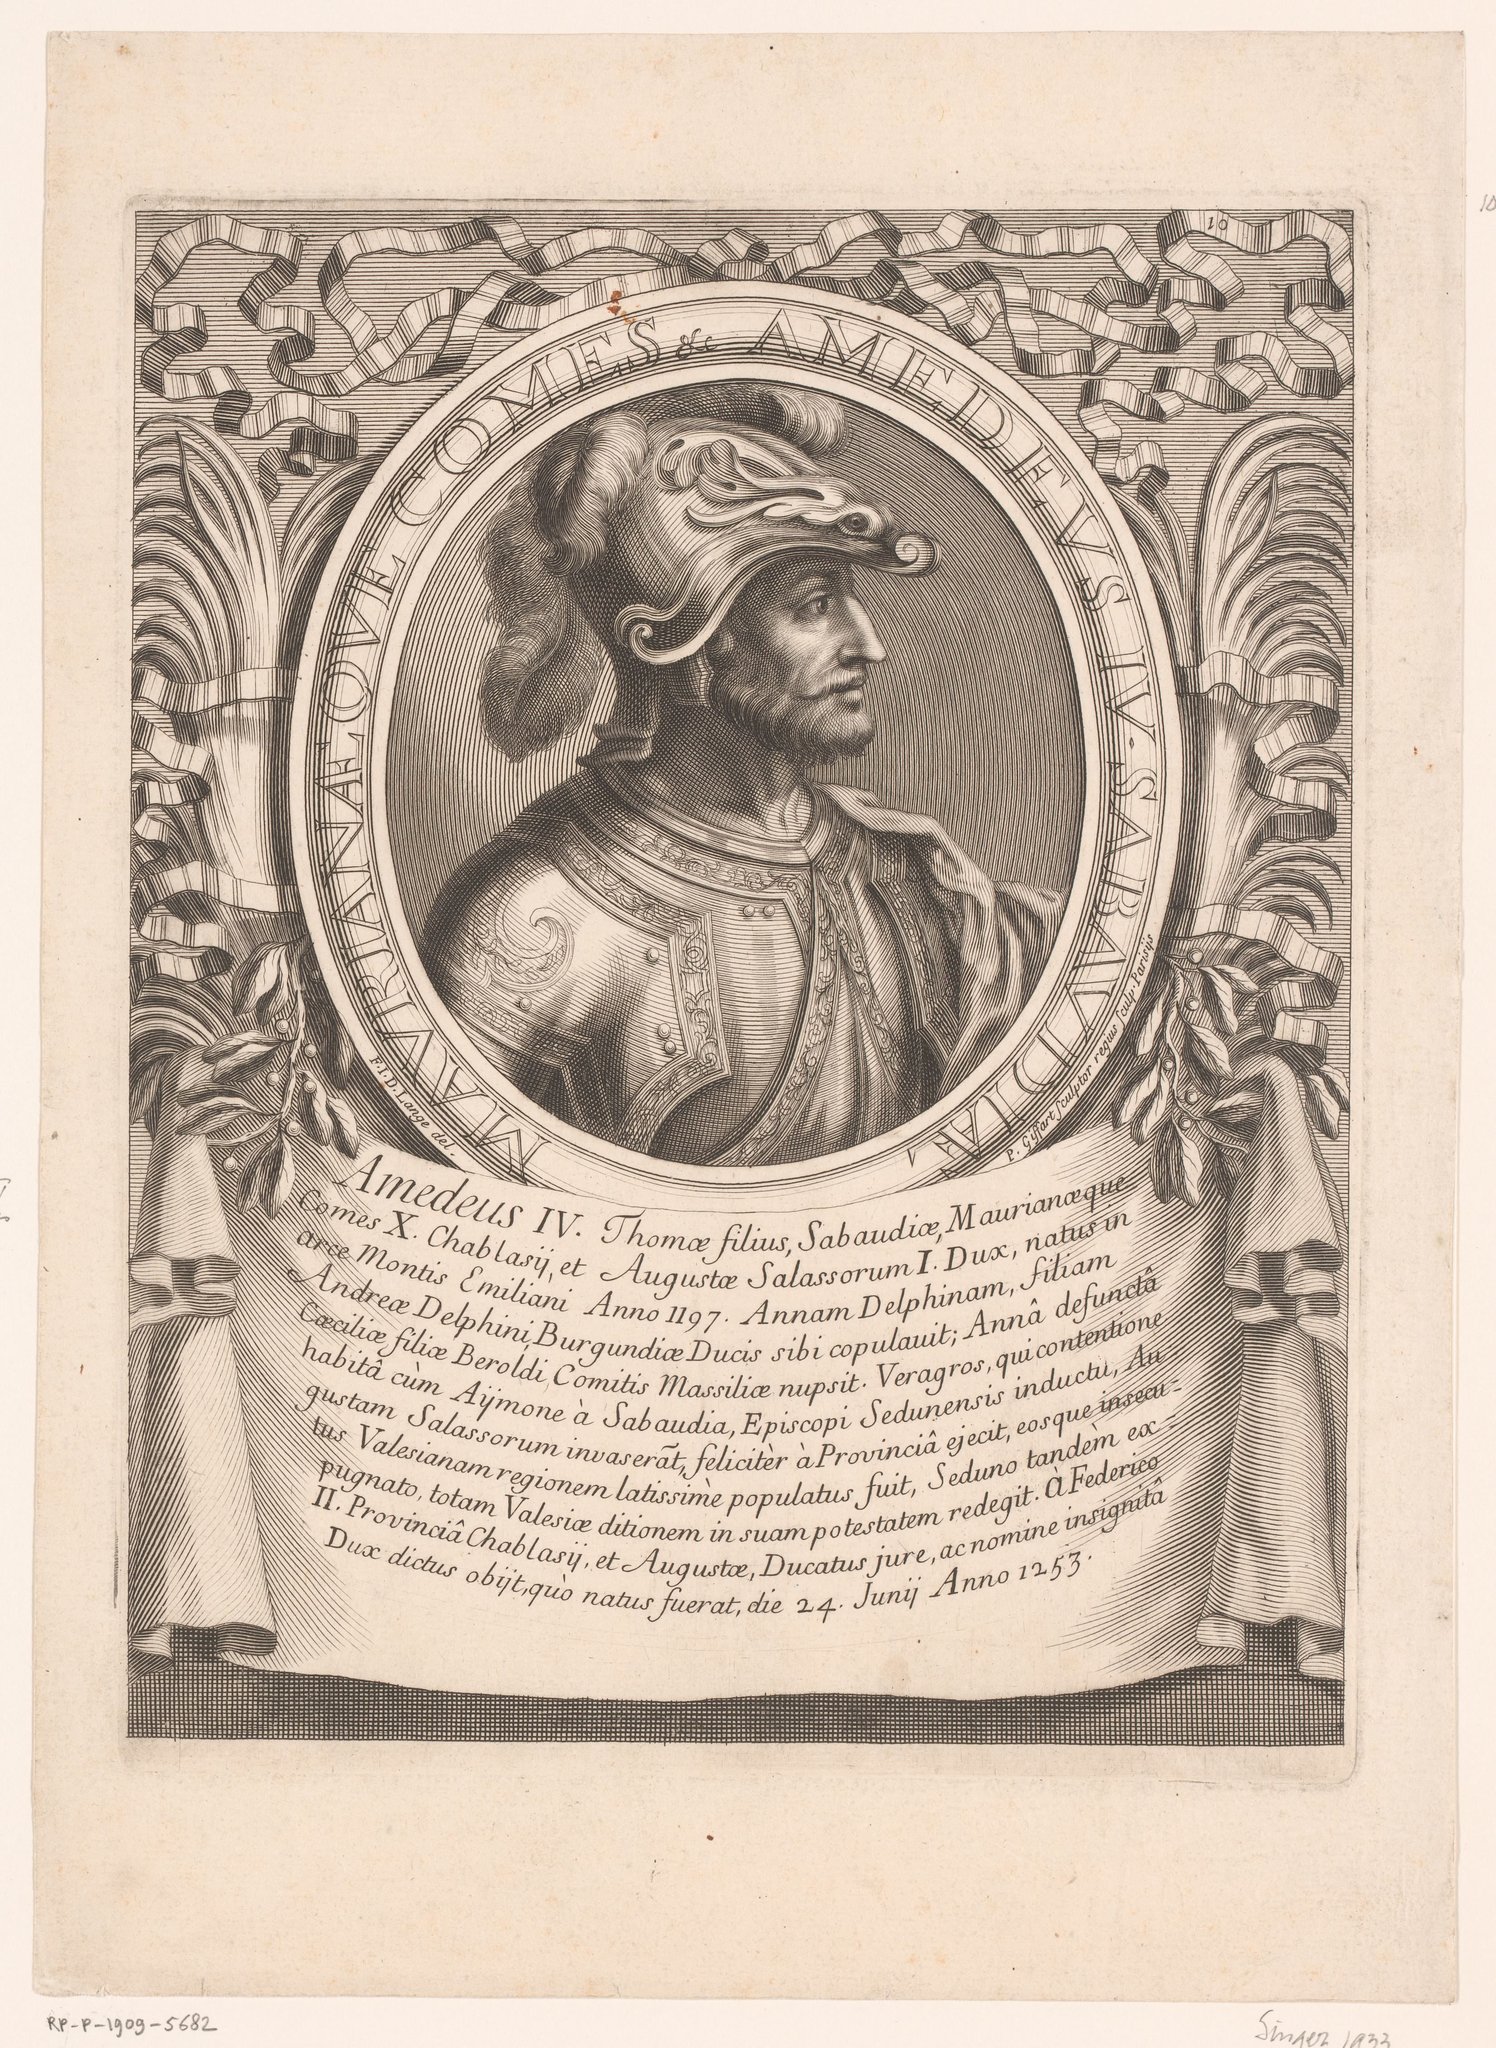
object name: print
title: Portret van Amadeus IV van Savoye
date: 1702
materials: paper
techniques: engraving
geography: paris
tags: historical persons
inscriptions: collector's mark: Lugt 2228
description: Maakt deel uit van een serie getiteld 'Augustae regiaeque Sabaudae domus Arbor gentilitia regiae celsitudini Victori Amedeo II' met portretten door Giffart en Tasnière van leden van het Huis van Savoye, uitgegeven in 1702 door Francesco Maria Ferrero di Lavriano.